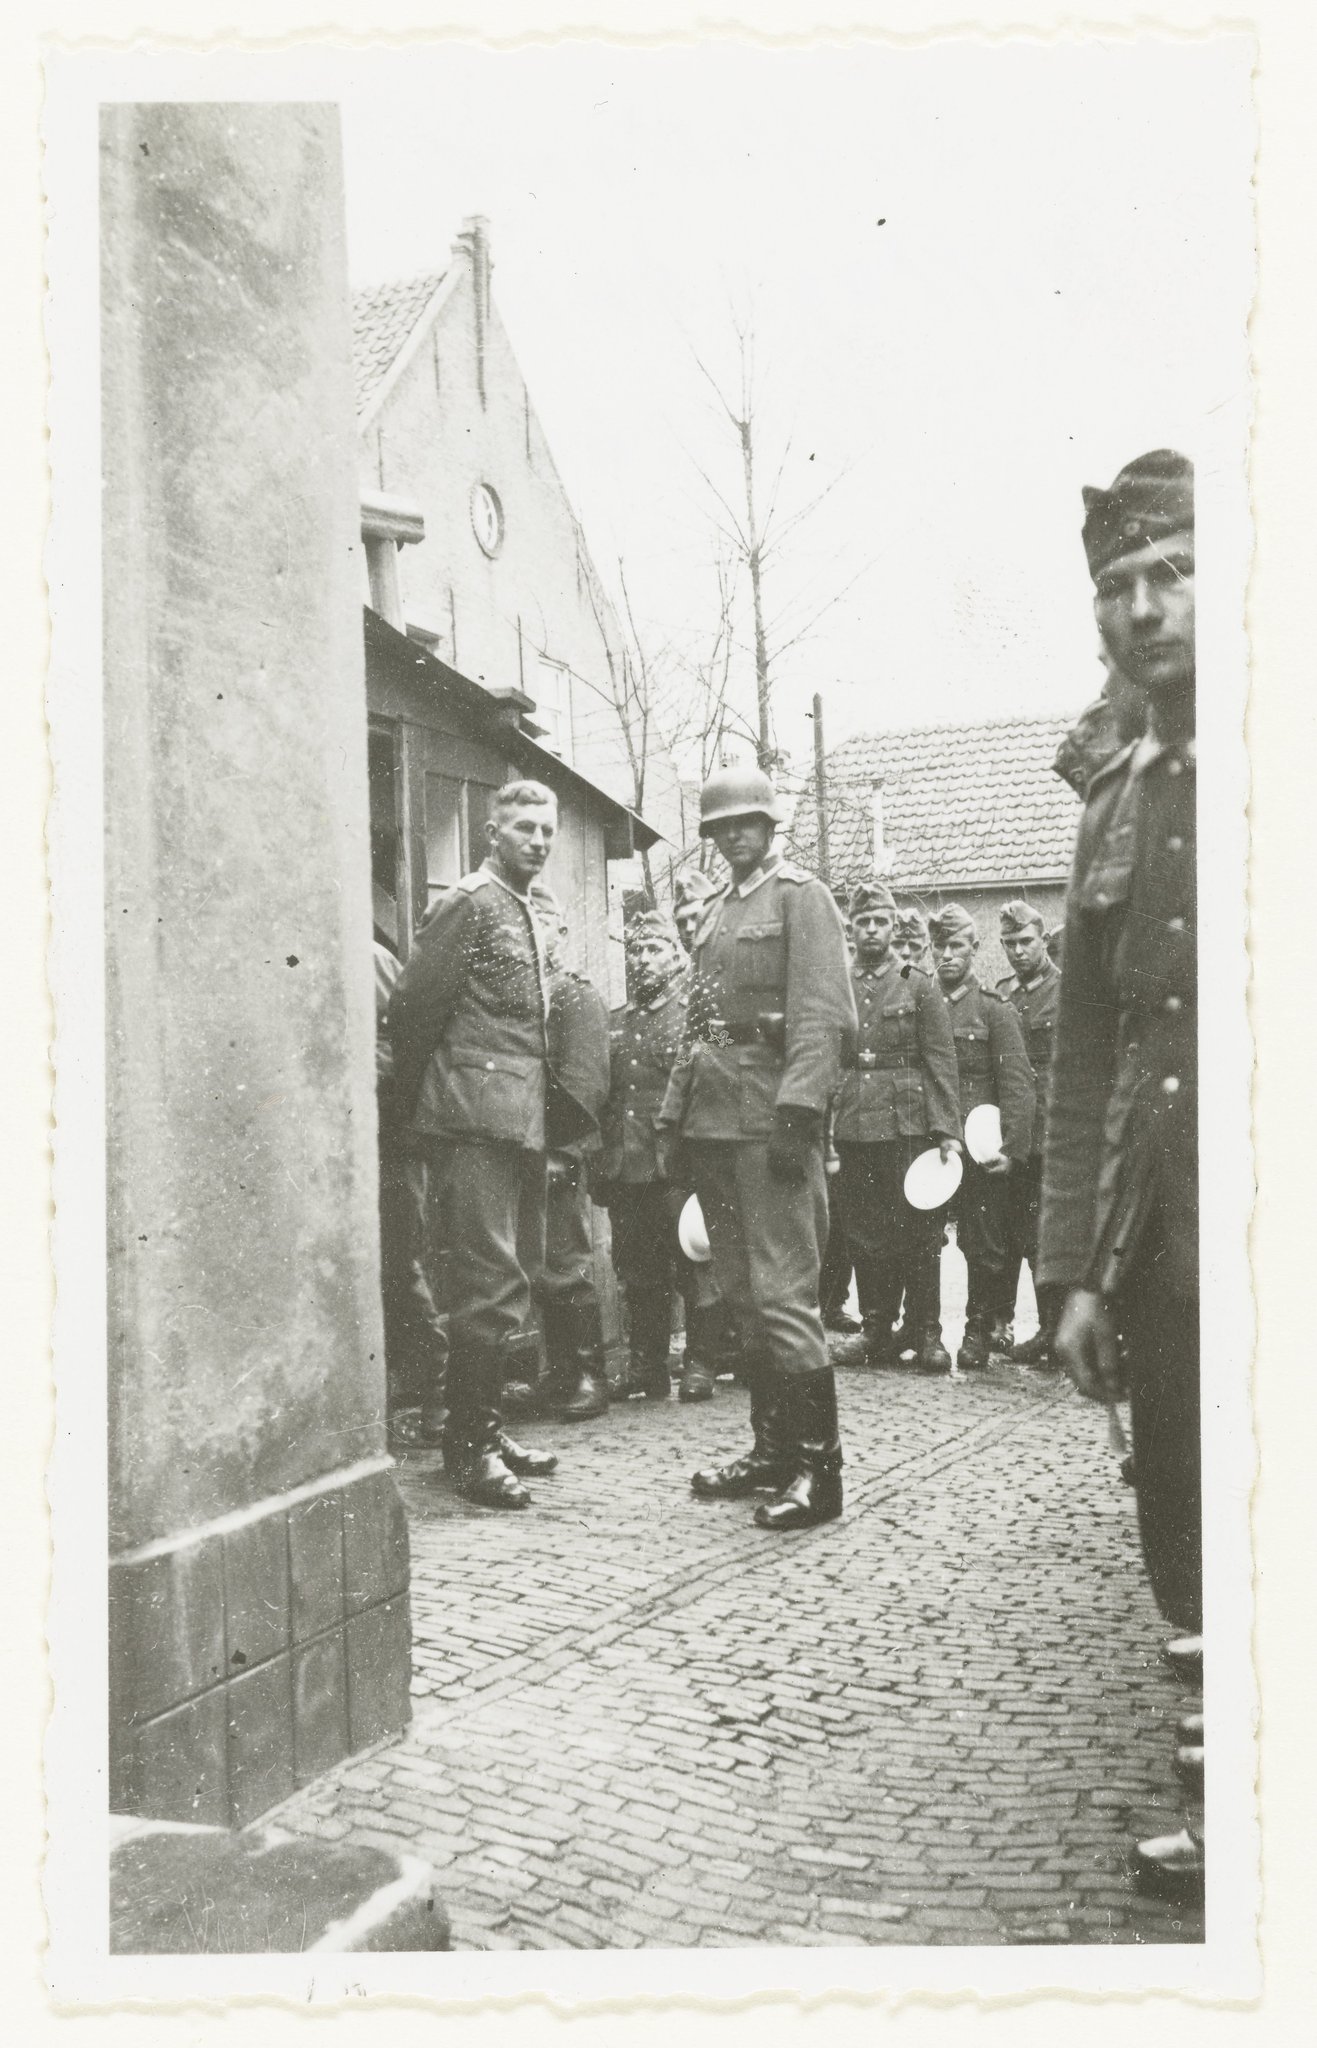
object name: photograph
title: Wehrmacht militairen bij de veldkeuken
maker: Anonymous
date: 1941-1942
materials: photographic support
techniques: gelatin silver print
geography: raamsdonksveer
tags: canteen ~ the soldier off duty, occupation ~ war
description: Een groep Duitse militairen staan te wachten bij een gebouw met borden in hun hand, de veldkeuken. Een draagt een helm. Achterop staat: In Holland. Mittags bei der Feldküche.